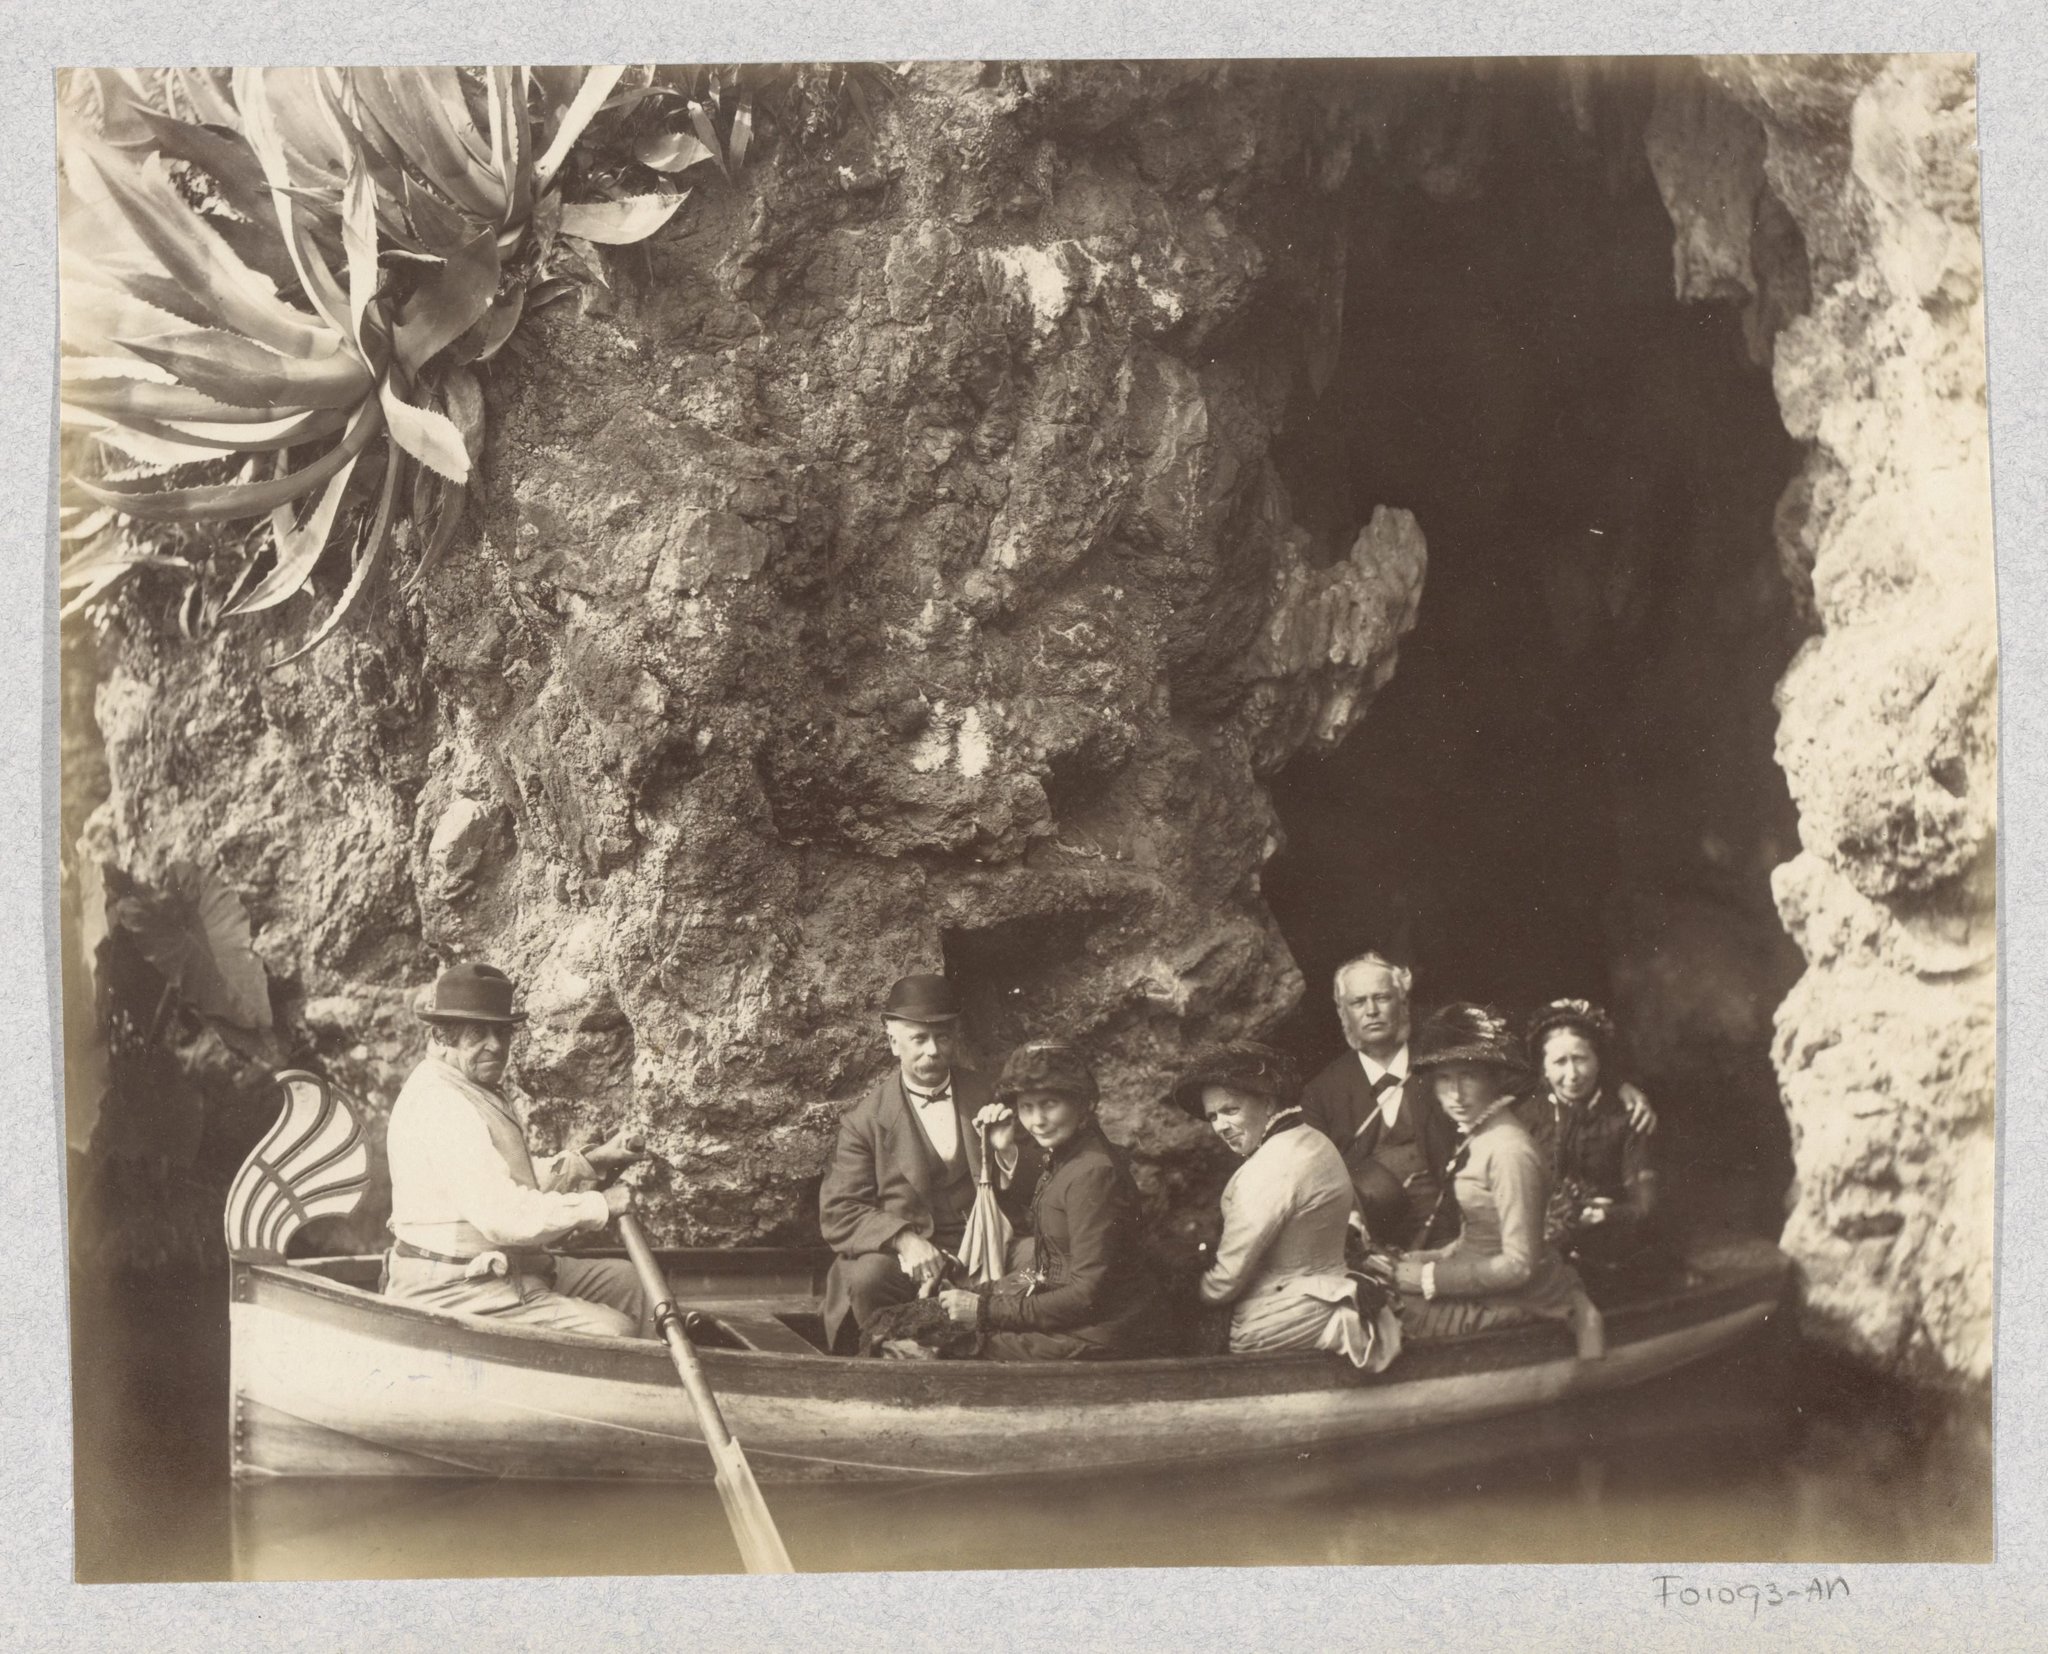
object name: photograph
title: Gezelschap in een roeiboot in een grot bij Villa Pallavicini te Pegli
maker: celestino degoix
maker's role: fotograaf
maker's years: 1825-1902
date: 1870-1890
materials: paper, photographic support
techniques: albumen print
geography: pegli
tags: rowing-boat, canoe, etc., cave, grotto, travelling; tourism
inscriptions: stamp: ‘Degoix, C. Photographe du Roi Via Nuovissima N. 7 Genova’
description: Onderdeel van Reisalbum met foto's van bezienswaardigheden in Genua, Florence en Venetië.